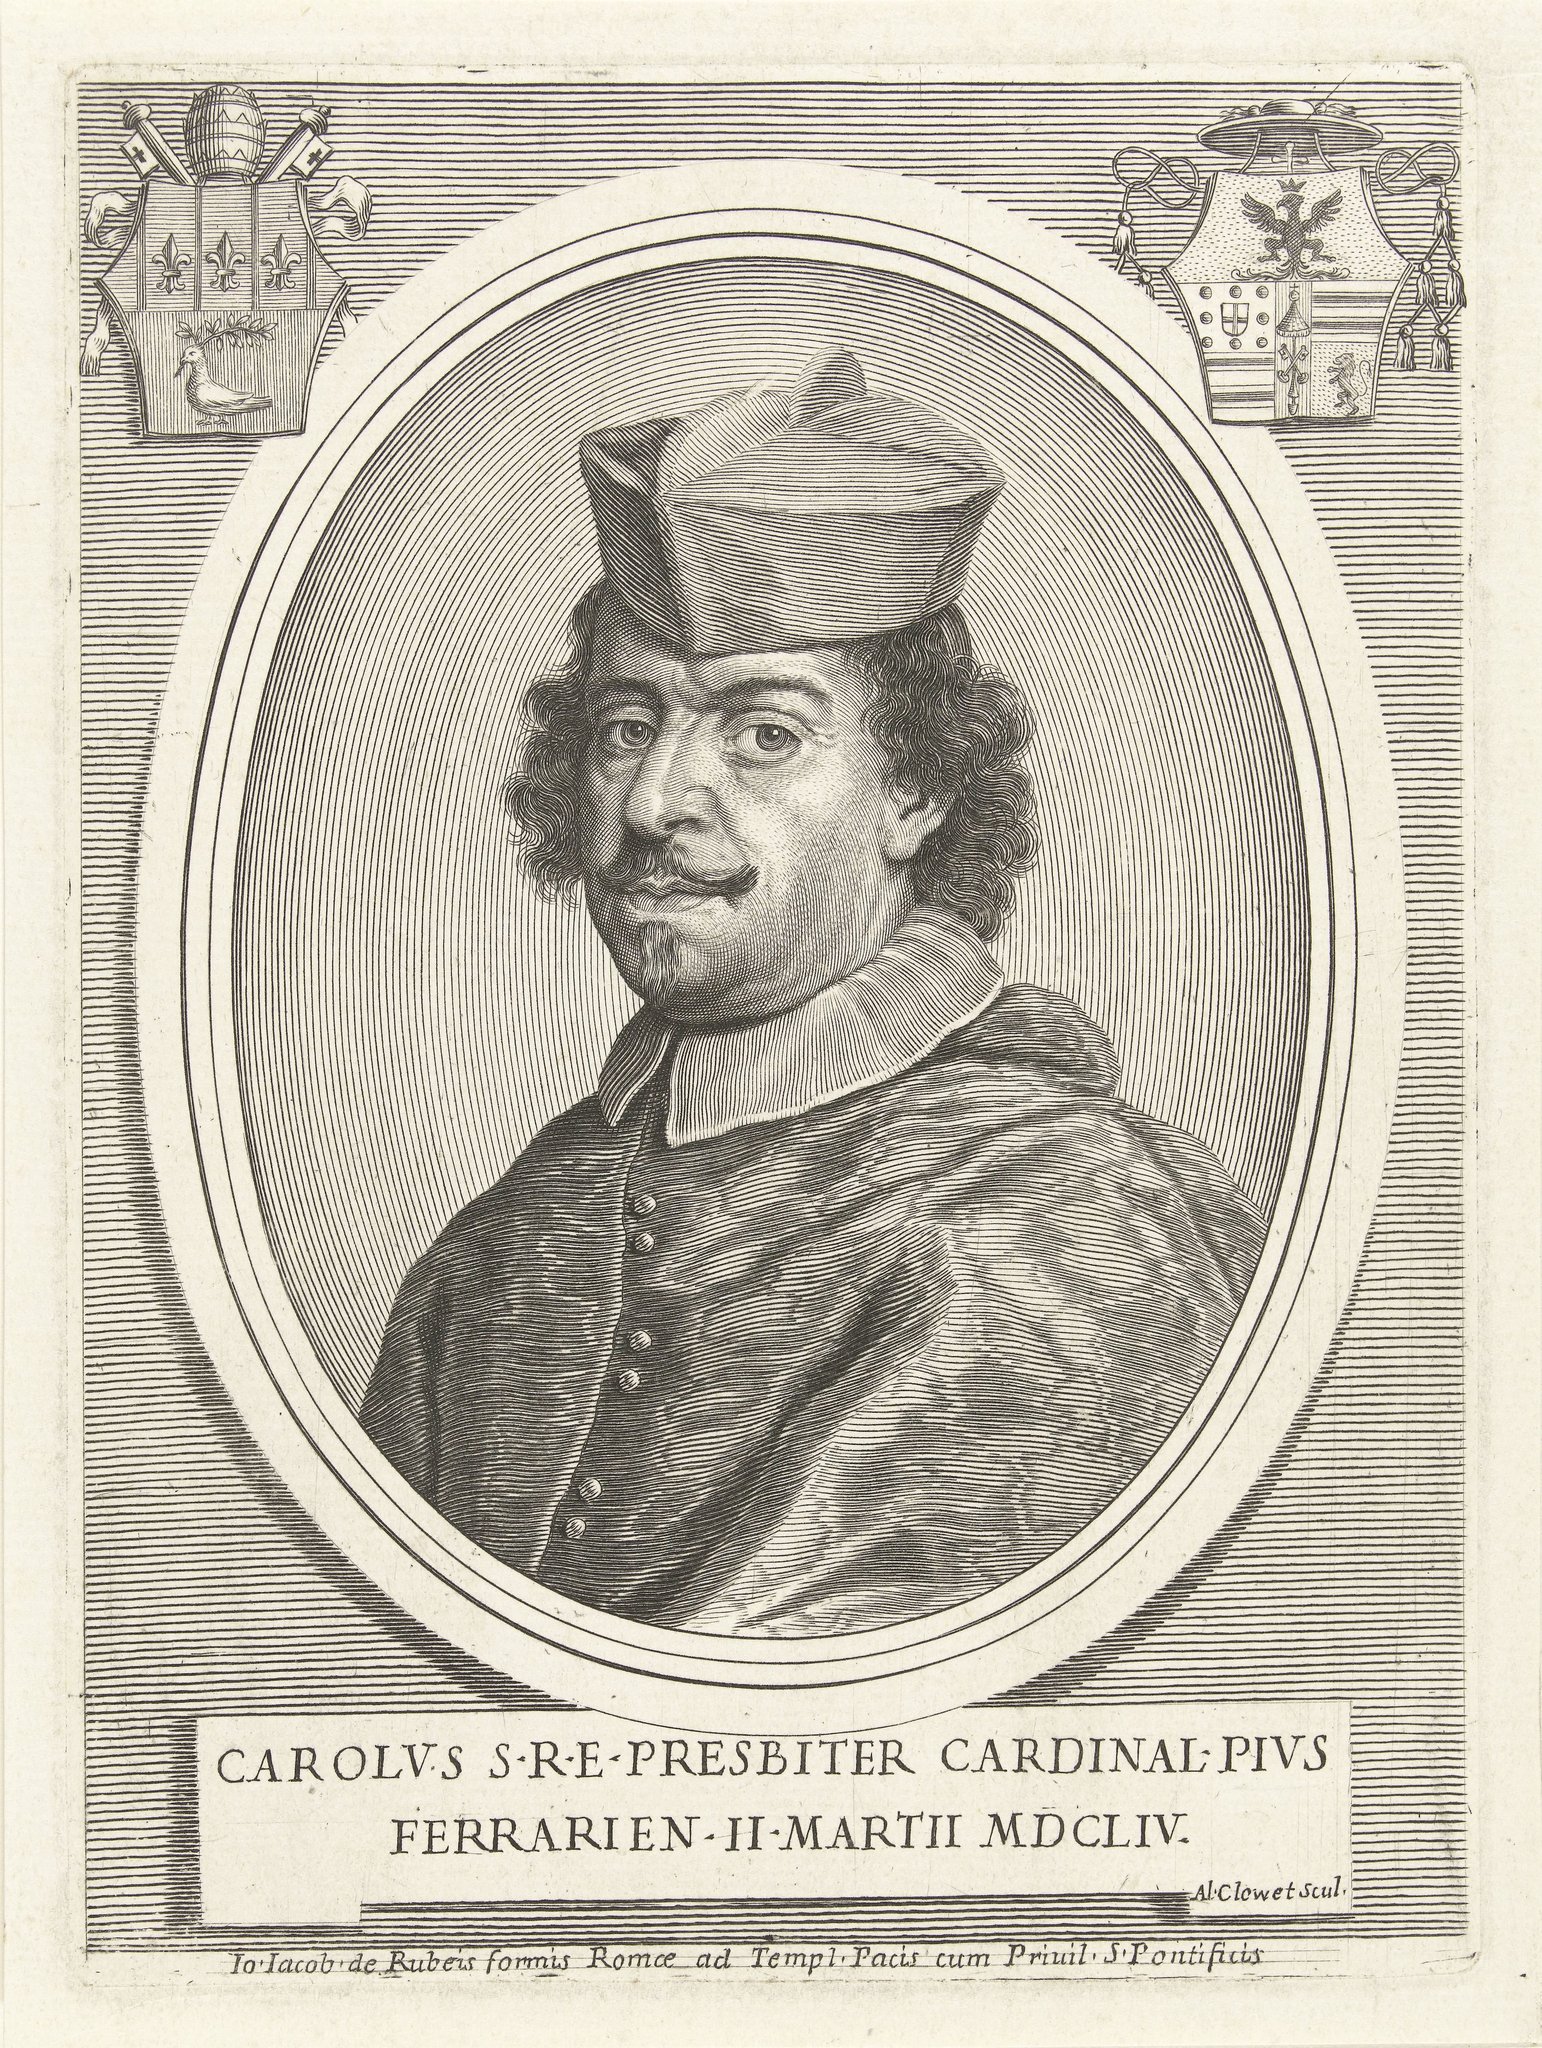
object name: print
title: Portret van kardinaal Carlo Pio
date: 1654-1679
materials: paper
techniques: engraving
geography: rome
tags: rome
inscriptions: collector's mark: Lugt 2228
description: Portret in ovale lijst van kardinaal Carlo Pio. Buste naar links. Bovenaan links het wapen van paus Innocentius XI, bovenaan rechts het wapen van kardinaal Carlo Pio. De prent heeft een Latijns onderschrift met gegevens over de geportretteerde.